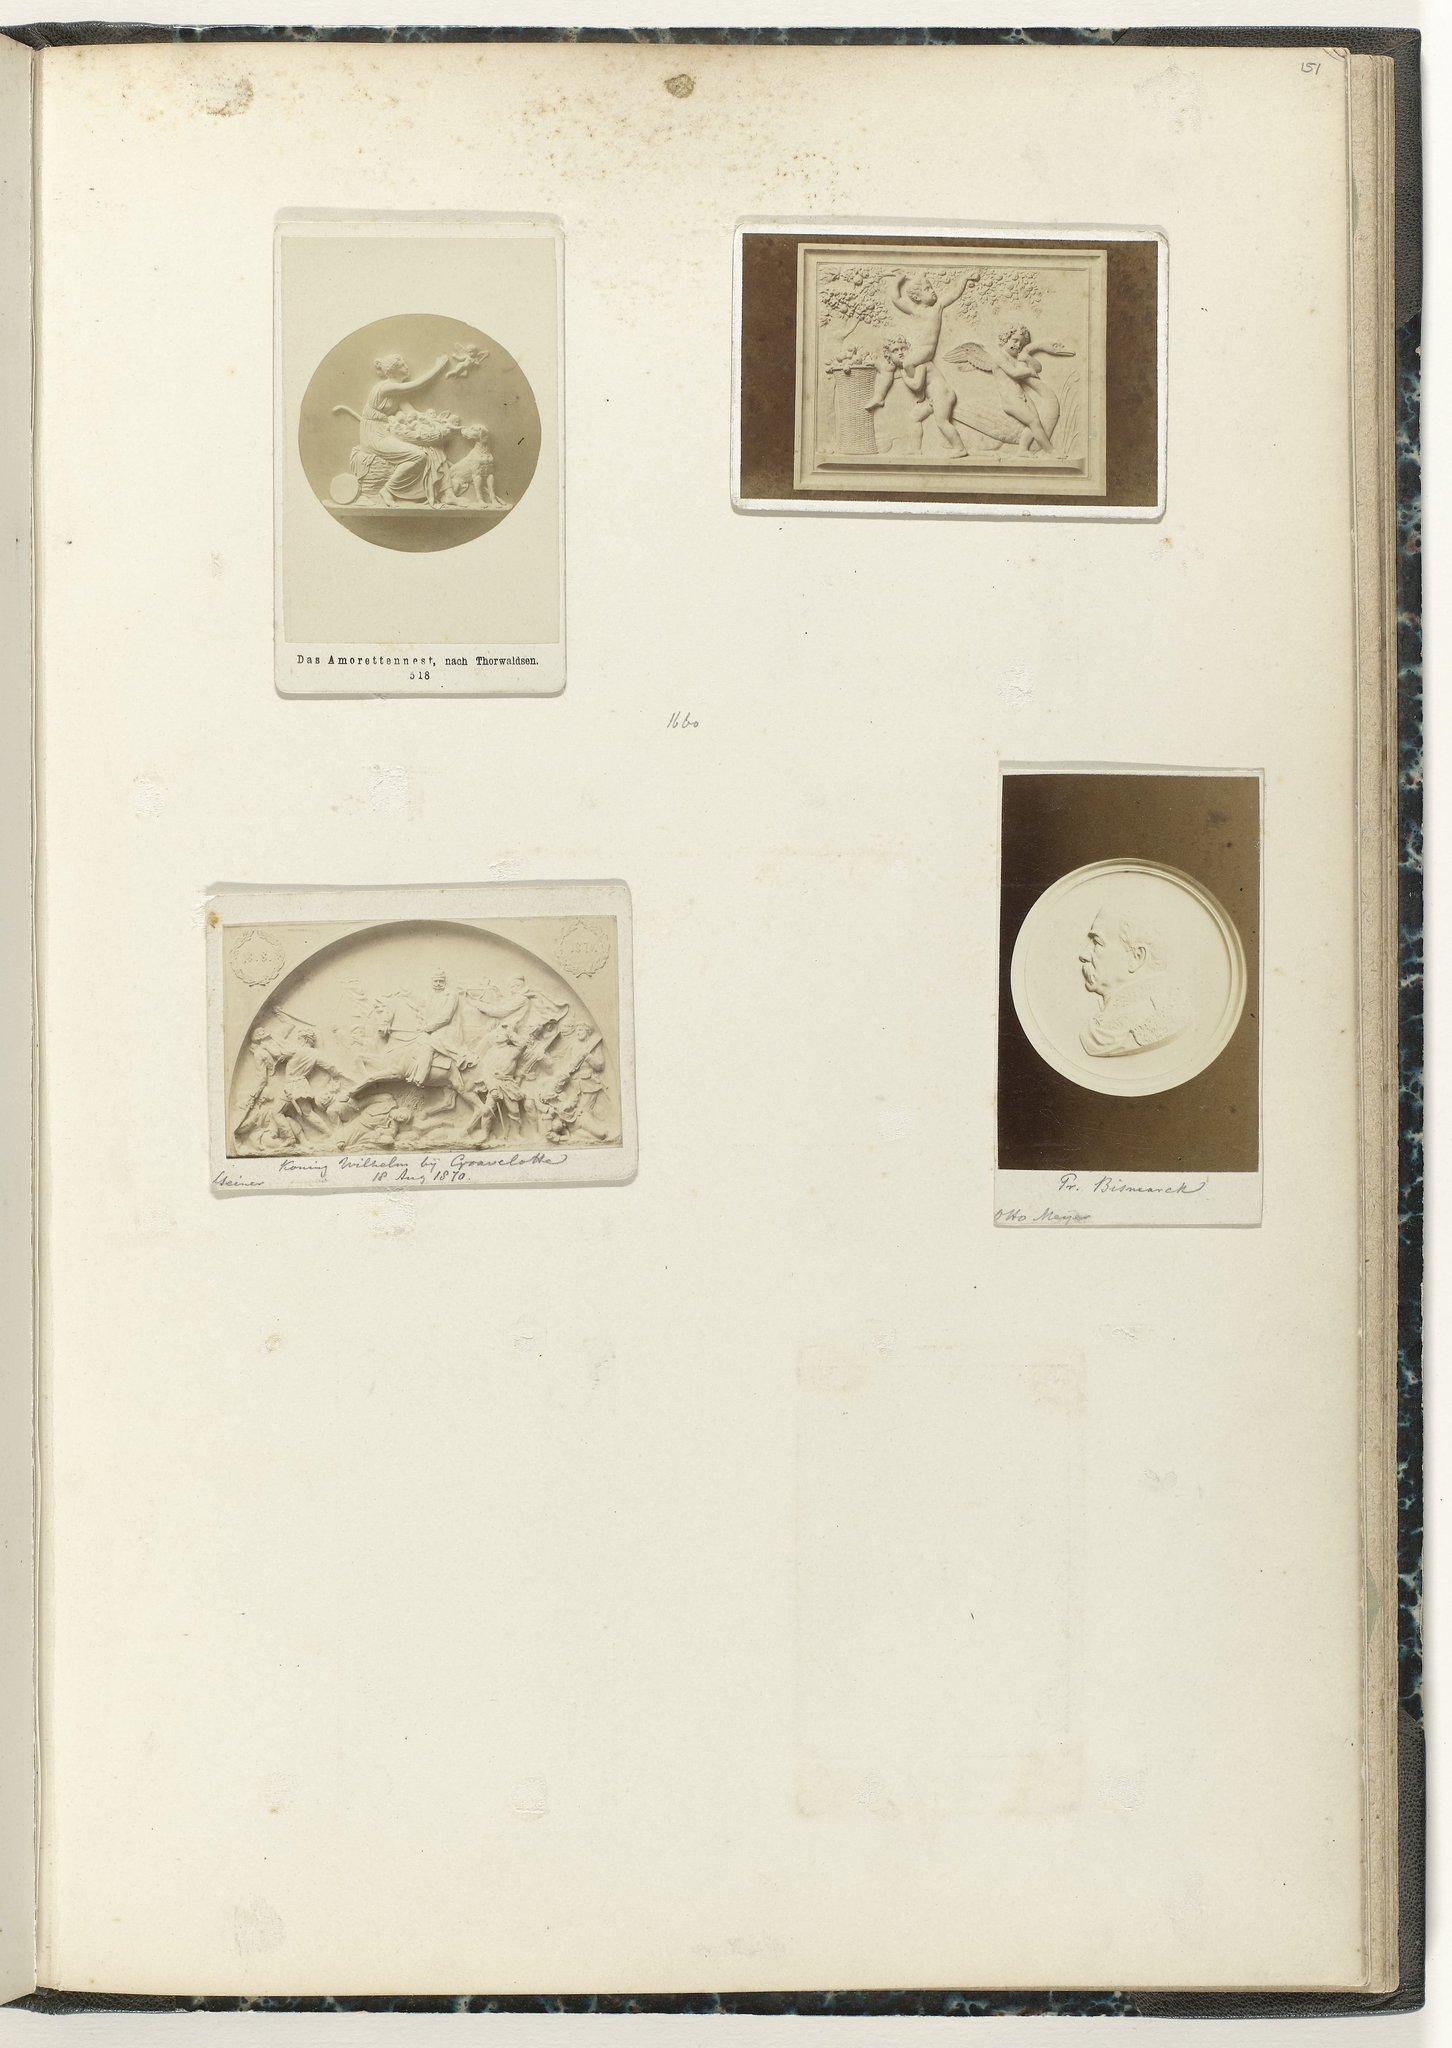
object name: photograph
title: Vier cartes-de-visite met twee ronde en twee rechthoekige ornamenten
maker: Anonymous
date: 1866-1900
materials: cardboard, paper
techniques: albumen print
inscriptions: annotation: ‘1660’, annotation: ‘Koning Wilhelm bij Gravelotte 18 Aug 1870.’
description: Op de cartes-de-visite staan van links naar rechts van boven naar beneden: een vrouw met een nest amoretti, drie putti waarvan er twee vruchten plukken terwijl de derde een zwaan vasthoudt, Koning Wilhelm bij Gravelotte en prins Bismarck. Das Amorettennest linksboven is naar Thorwaldsen, bij de sculptuur linksonder staat in potlood de naam Steiner vermeld en bij het portretmedaillon rechtsonder de naam Otto Meijer.